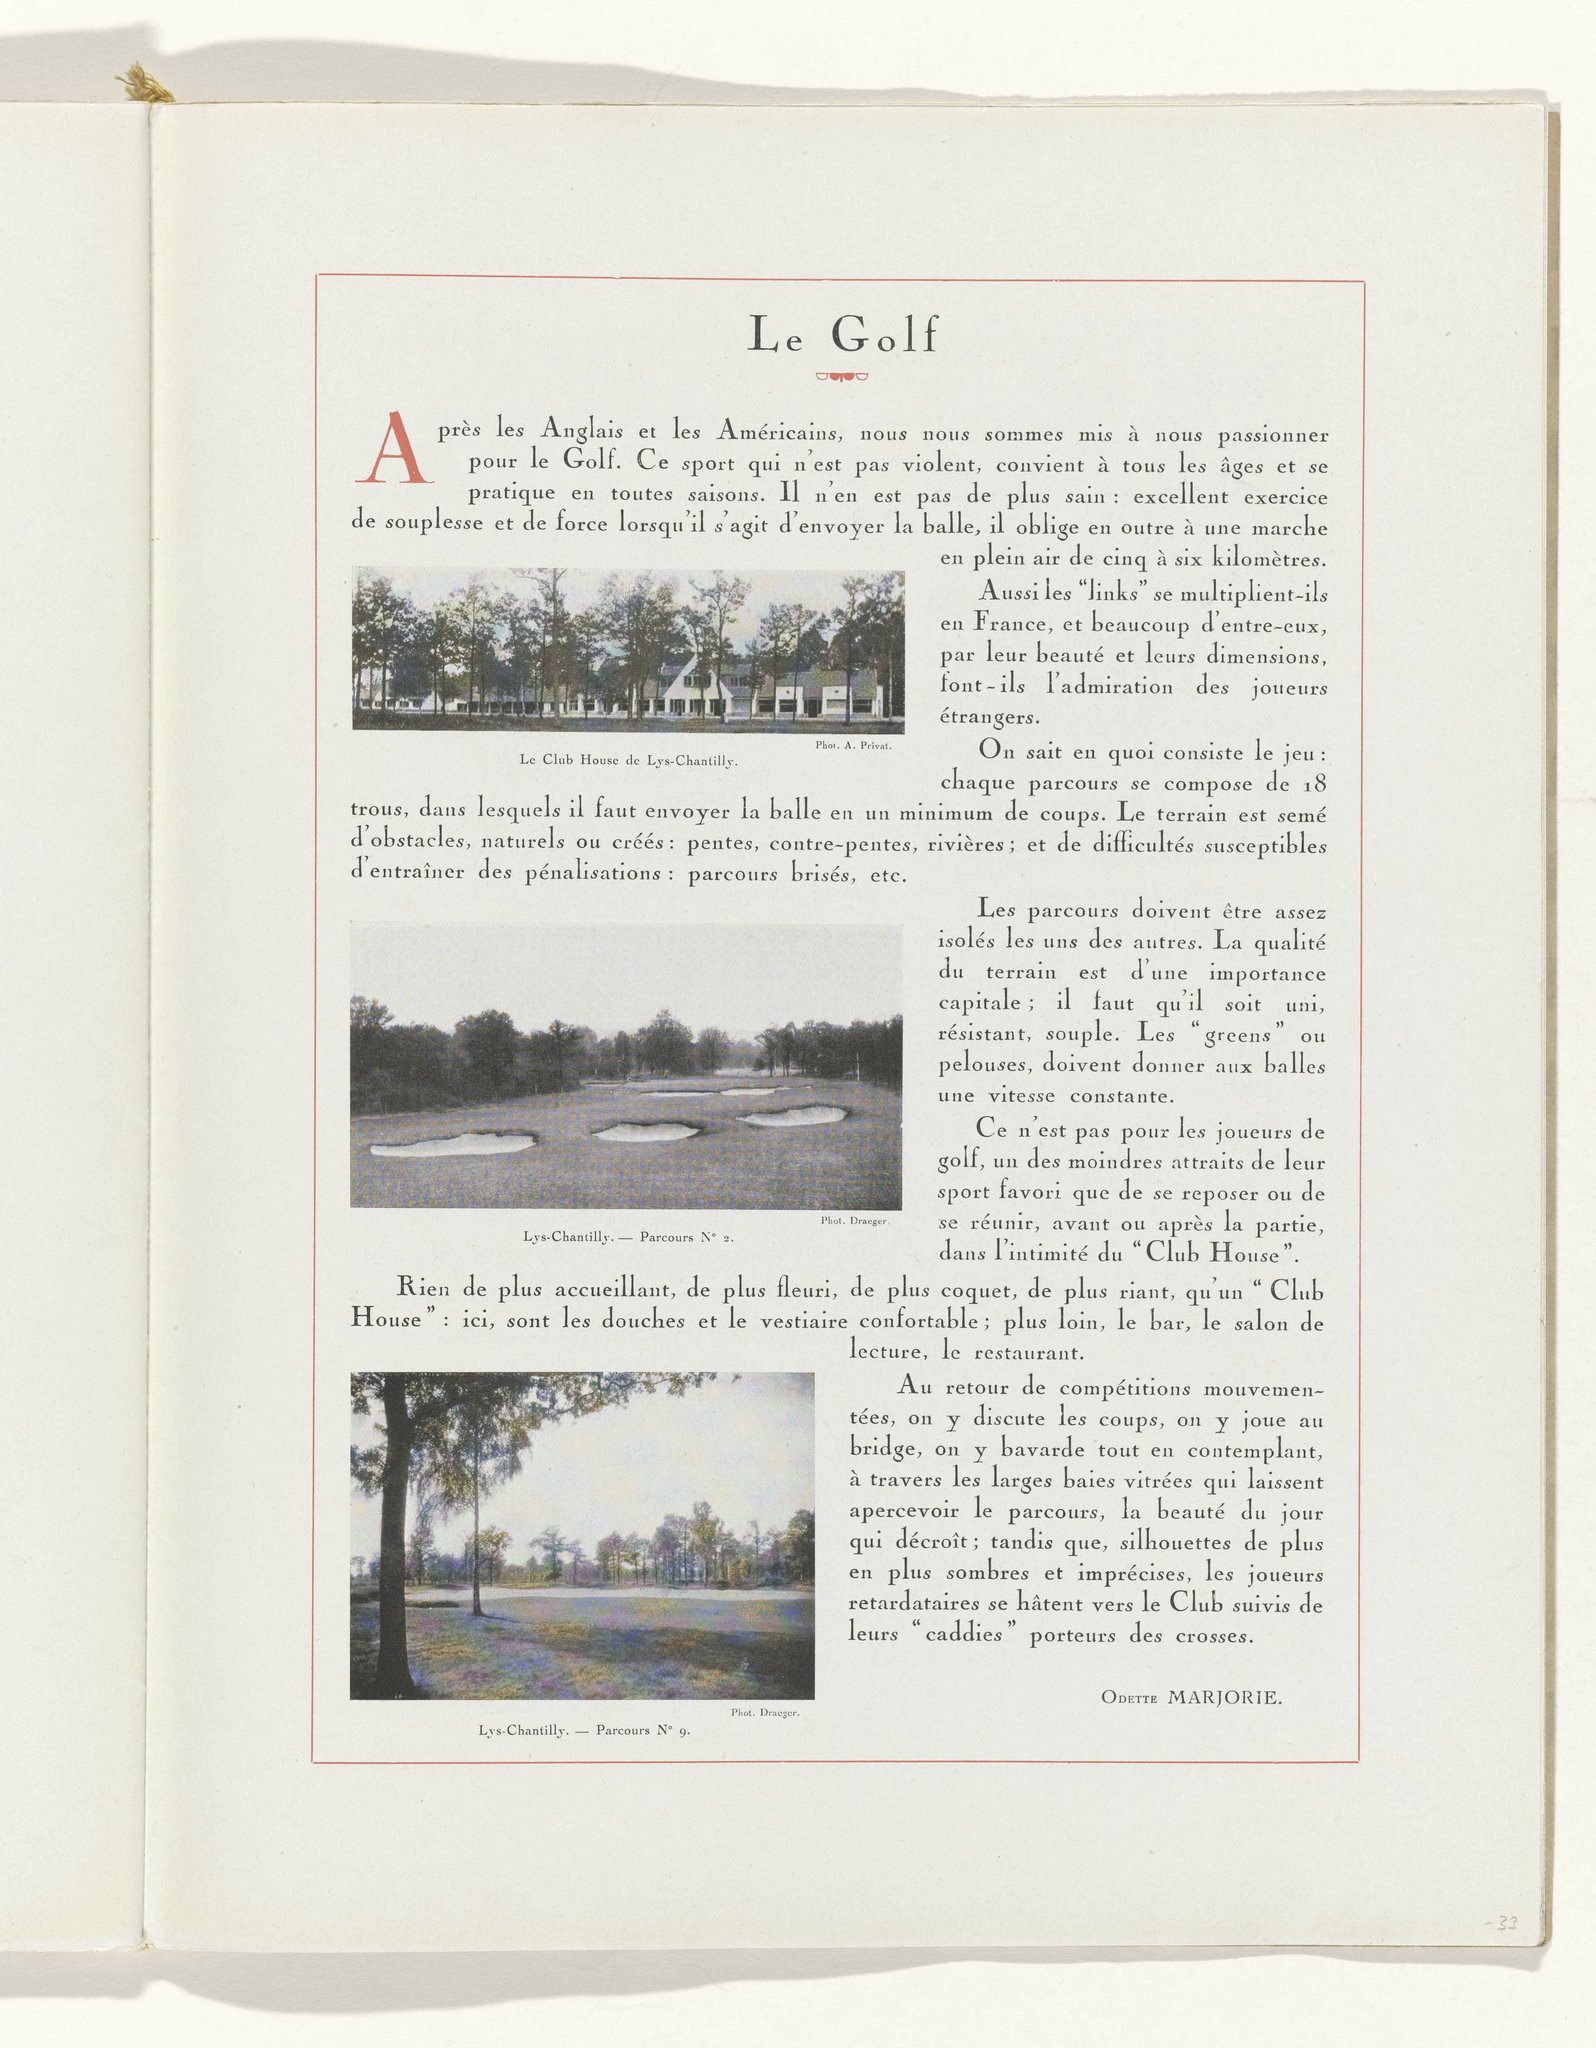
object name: fashion print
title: Art - Goût - Beauté, Feuillets de l' élégance féminine, Juin 1932, No. 142, 12e Année, p. 33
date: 1932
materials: paper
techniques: printing, photography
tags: golf (+ out of doors (sports, games, etc.)), fashion plates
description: Tekst 'Le Golf' met drie foto's van het clubhuis van Lys-Chantilly en golf parcours No 2 en No 9. Pagina uit het modetijdschrift Art-Goût-Beauté (1920-1933).